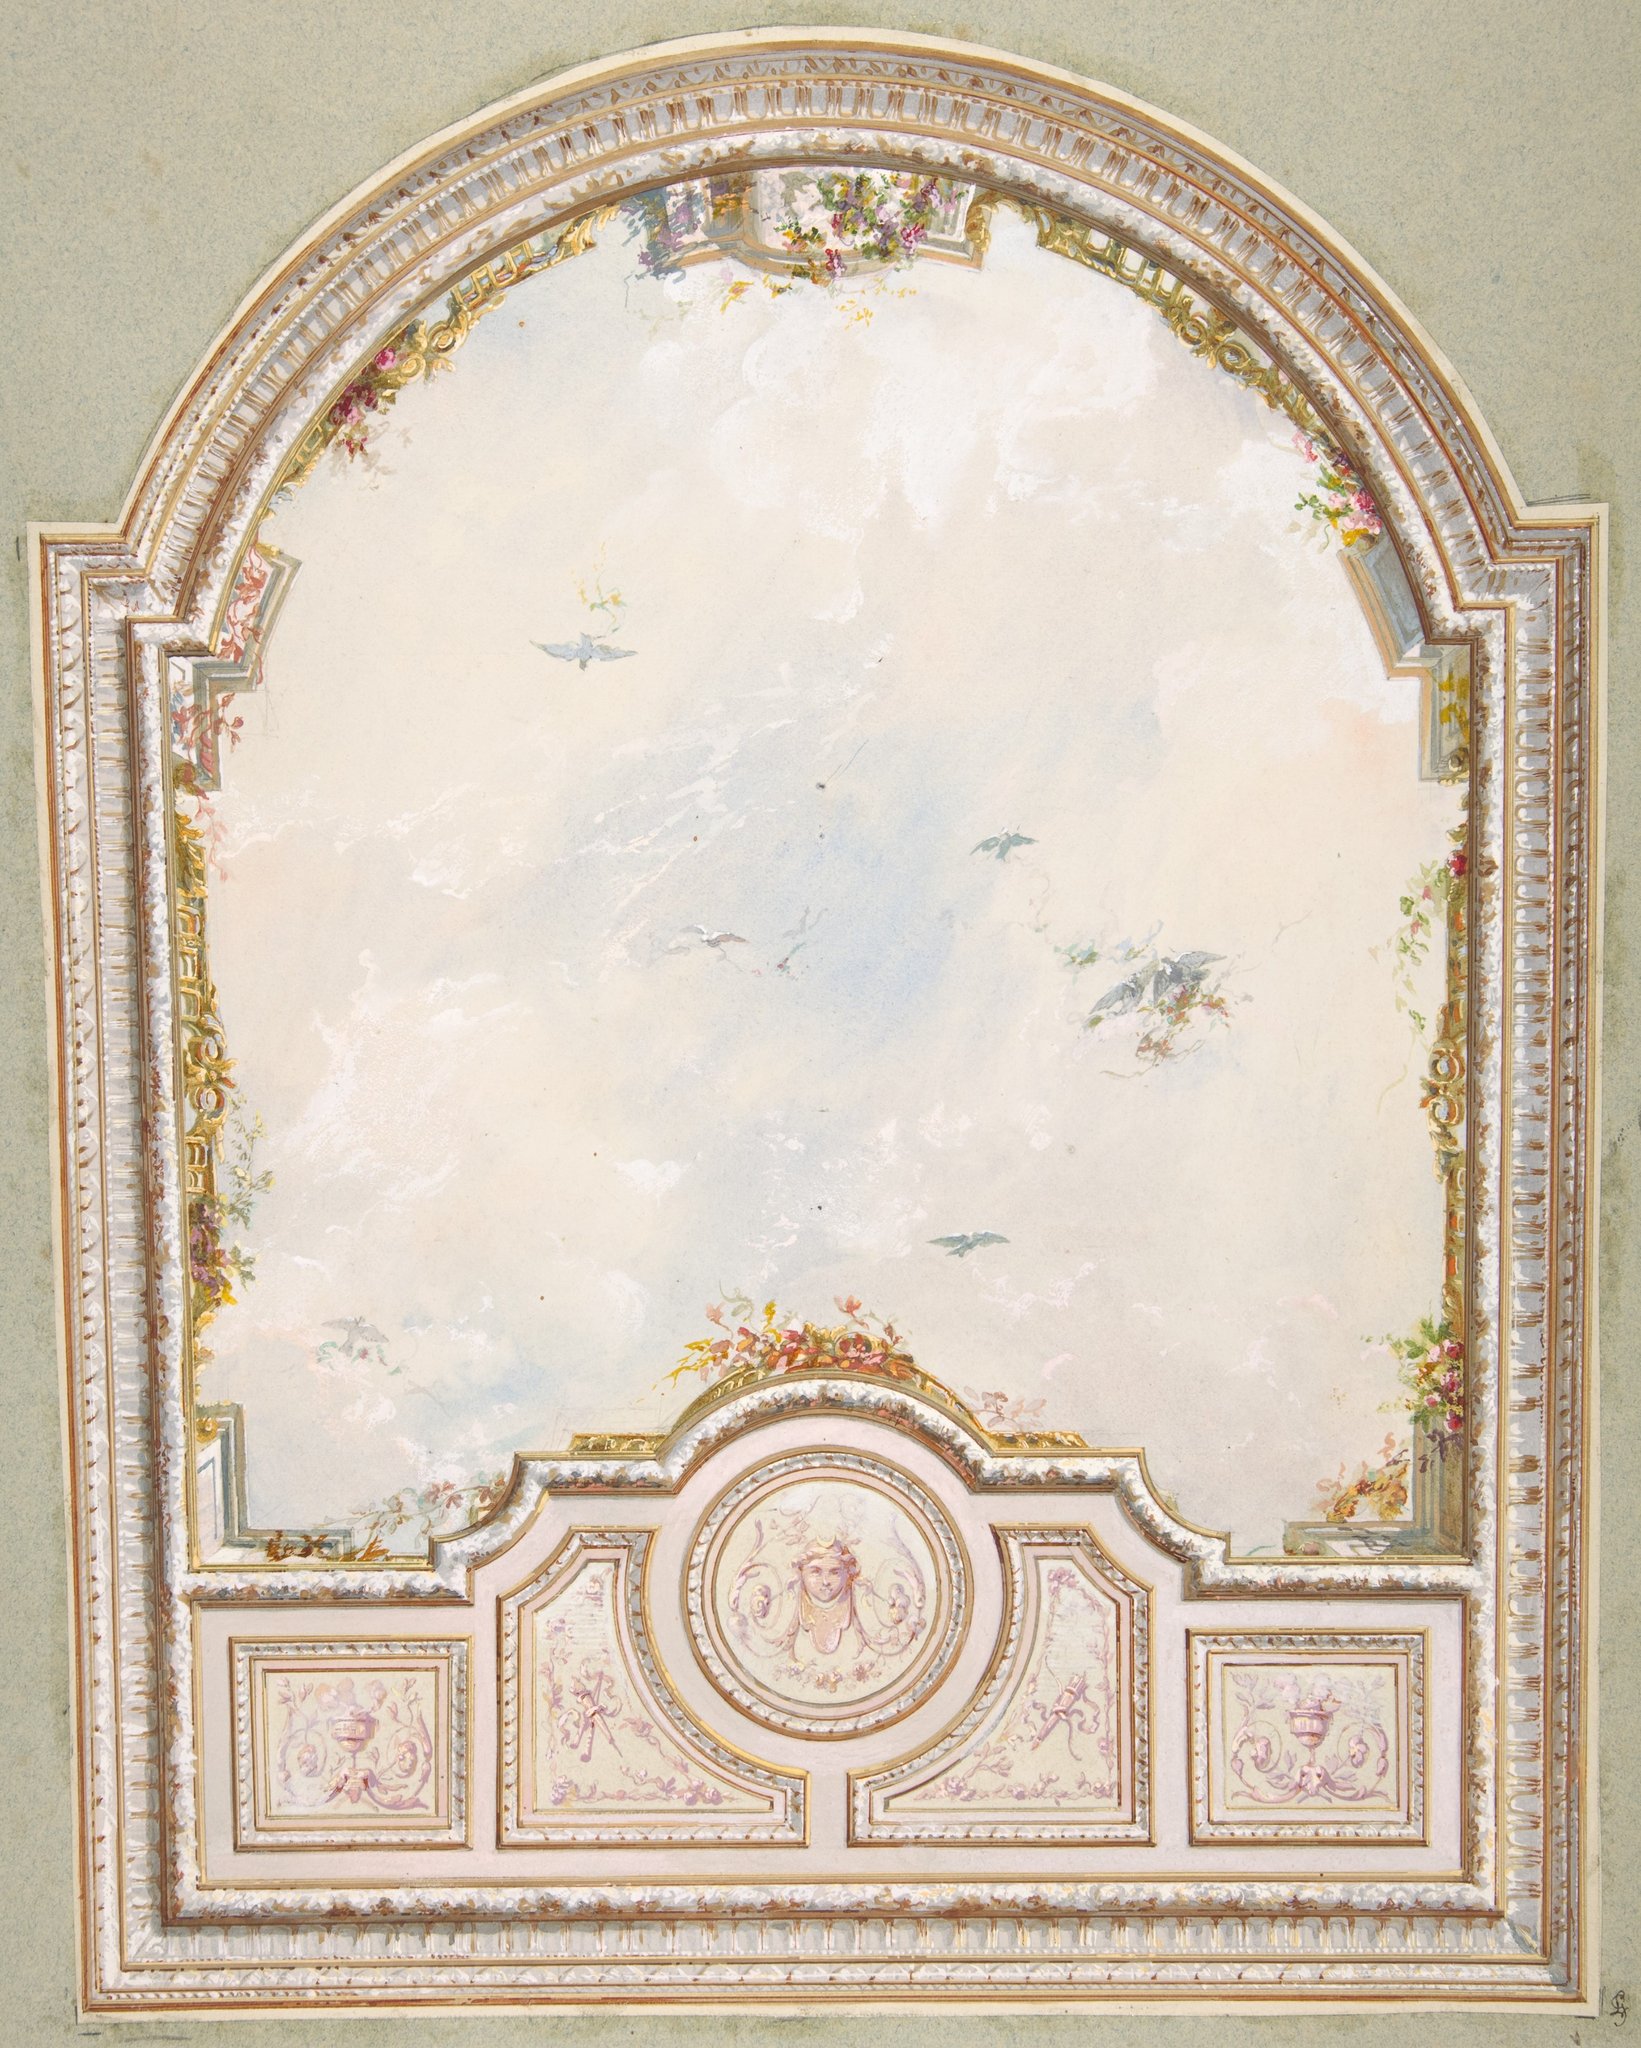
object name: drawing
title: Deign for a ceiling a a trompe l'oeil sky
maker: jules-edmond-charles lachaise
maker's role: artist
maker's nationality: french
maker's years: 1897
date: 1851-1900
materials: gouache, graphite, ink, watercolor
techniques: pen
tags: birds,faces,sky